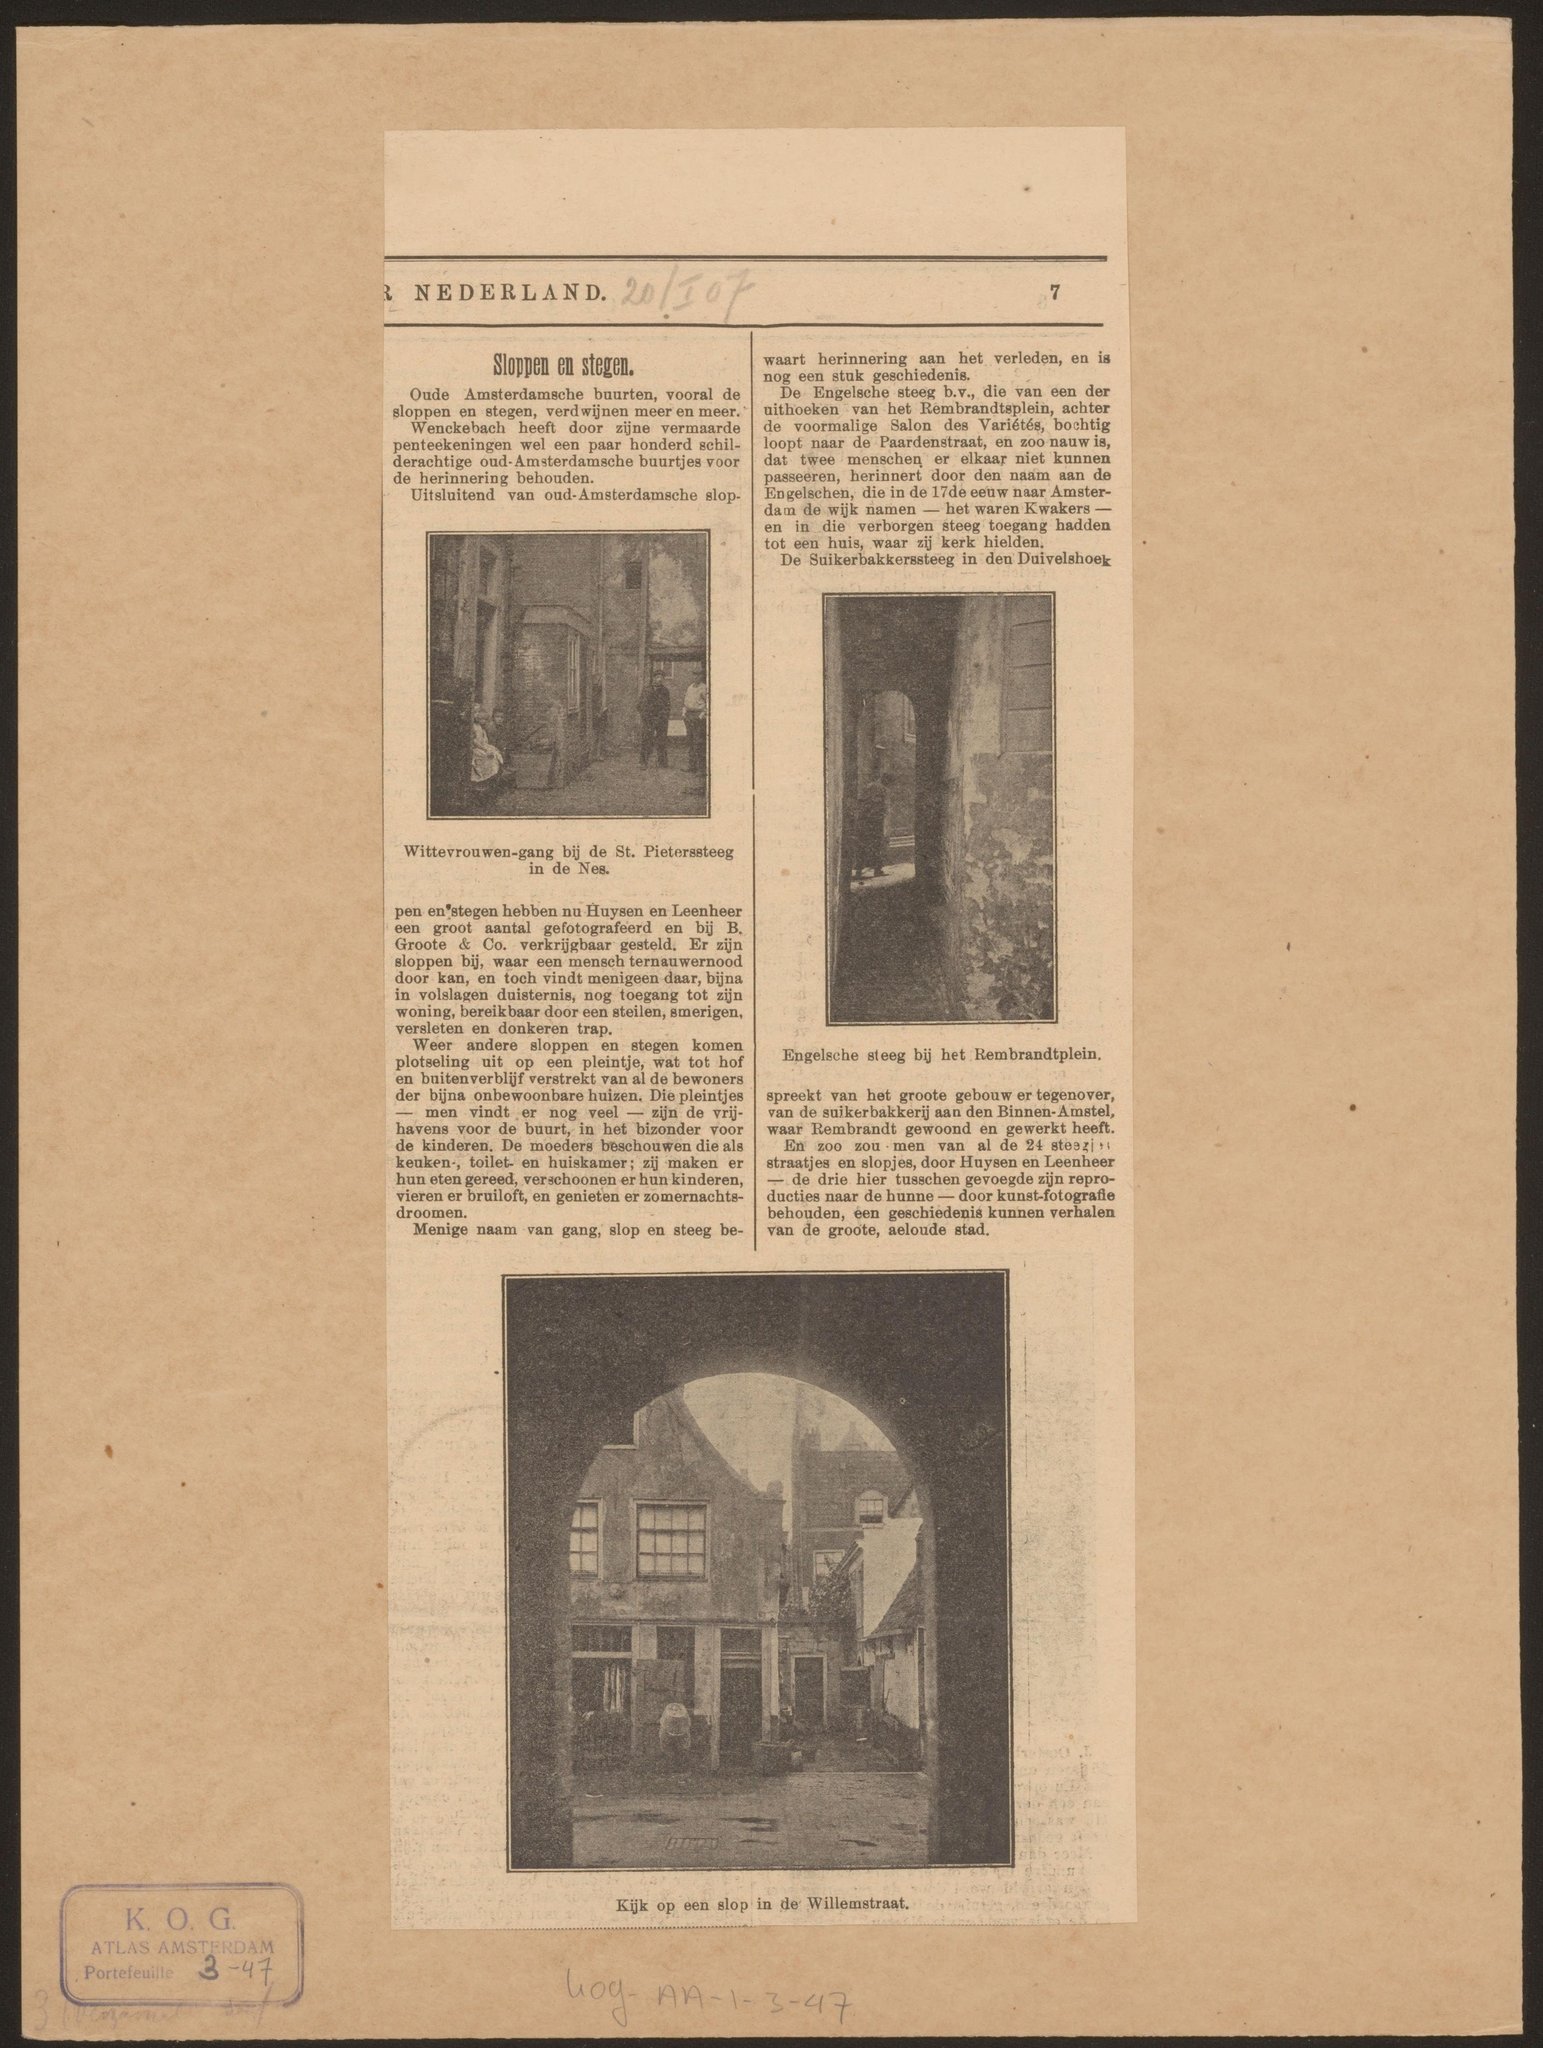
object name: photomechanical print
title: Gezichten op drie stegen te Amsterdam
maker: Anonymous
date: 1880-1925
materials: paper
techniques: letterpress printing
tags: city-view in general; 'veduta', lane, alley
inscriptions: collector's mark: ‘3-47’ Lugt 1641b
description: Onderwerpsrubriek binnen de Atlas Amsterdam: Verzamelbladen gangen, sloppen en stegen. Gezichten op de Sint Pieterssteeg, de Engelsesteeg en de Willemstraat.